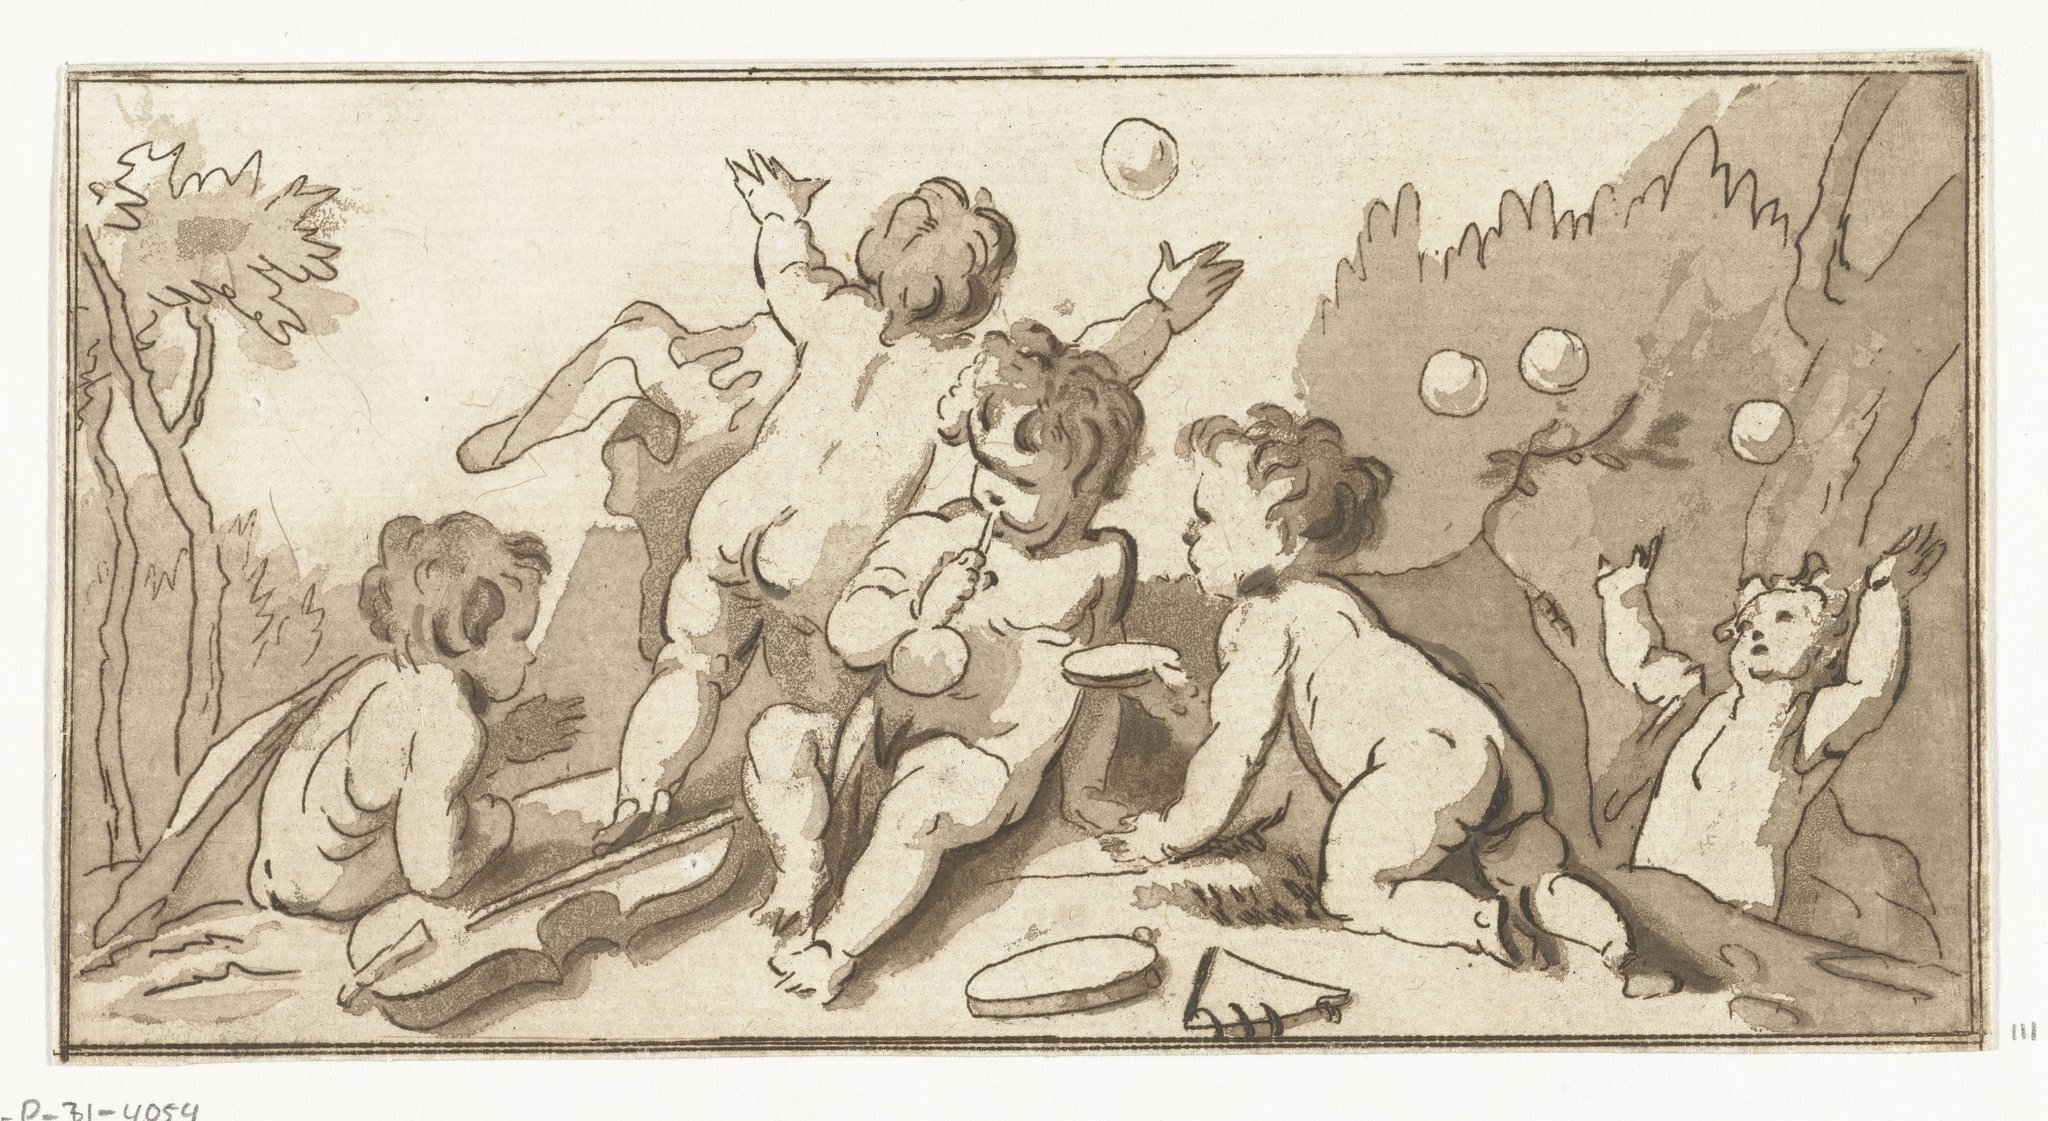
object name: print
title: Bellenblazende putti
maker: anthonie van den bos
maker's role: draughtsman, print maker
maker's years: 1763-1838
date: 1778-1838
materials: paper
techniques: aquatint, etching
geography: netherlands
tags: (children or putti) blowing bubbles, 'homo bulla' ~ scene symbolizing 'vanitas'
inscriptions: collector's mark: Lugt 2228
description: Vijf putti zitten op een heuvel. Een van hen blaast bellen, de anderen proberen de bellen te vangen.